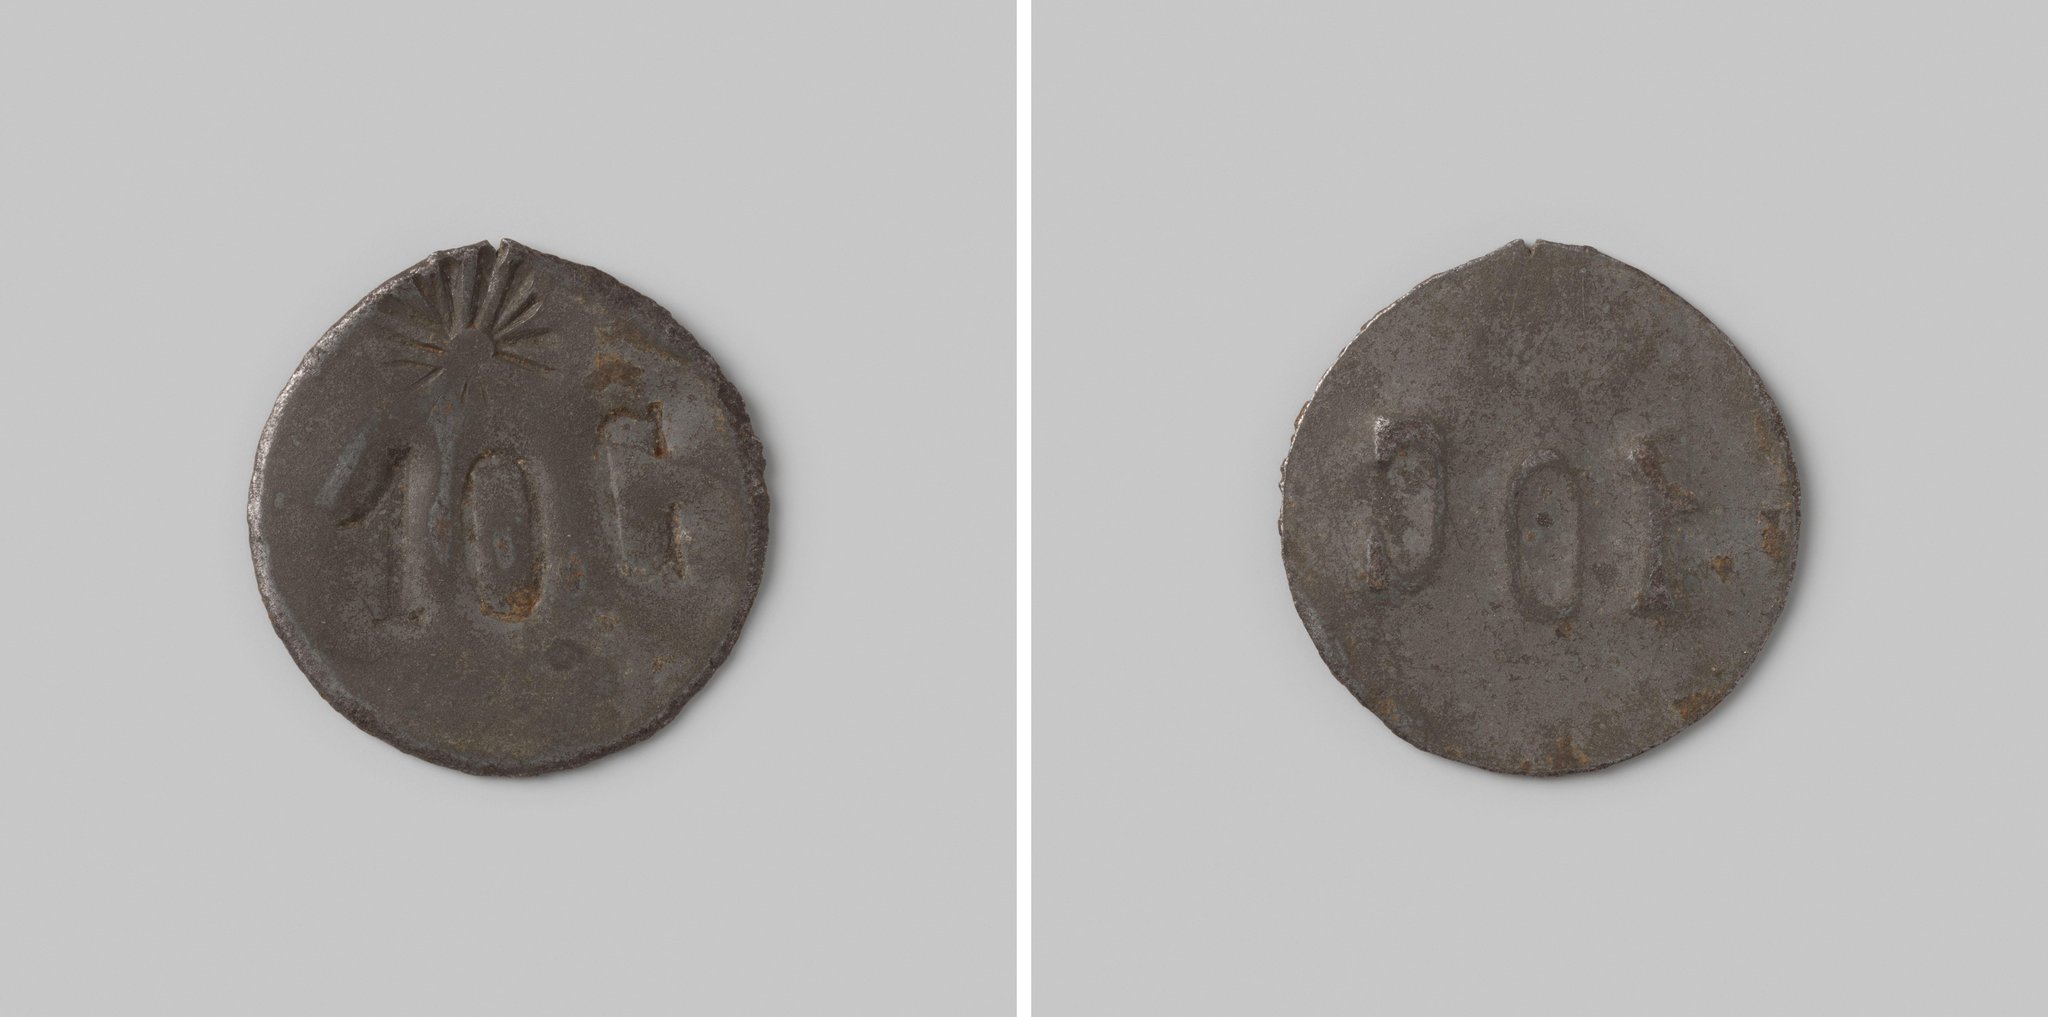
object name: history medal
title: Betaalpenning van 10 cents van de Coöperatieve Winkelvereeniging Eendracht Maakt Magt te Hilversum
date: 1875-1900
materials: zinc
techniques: printing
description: Rond zinken plaatje met inwaartse instempelingen (ster) / 10 C